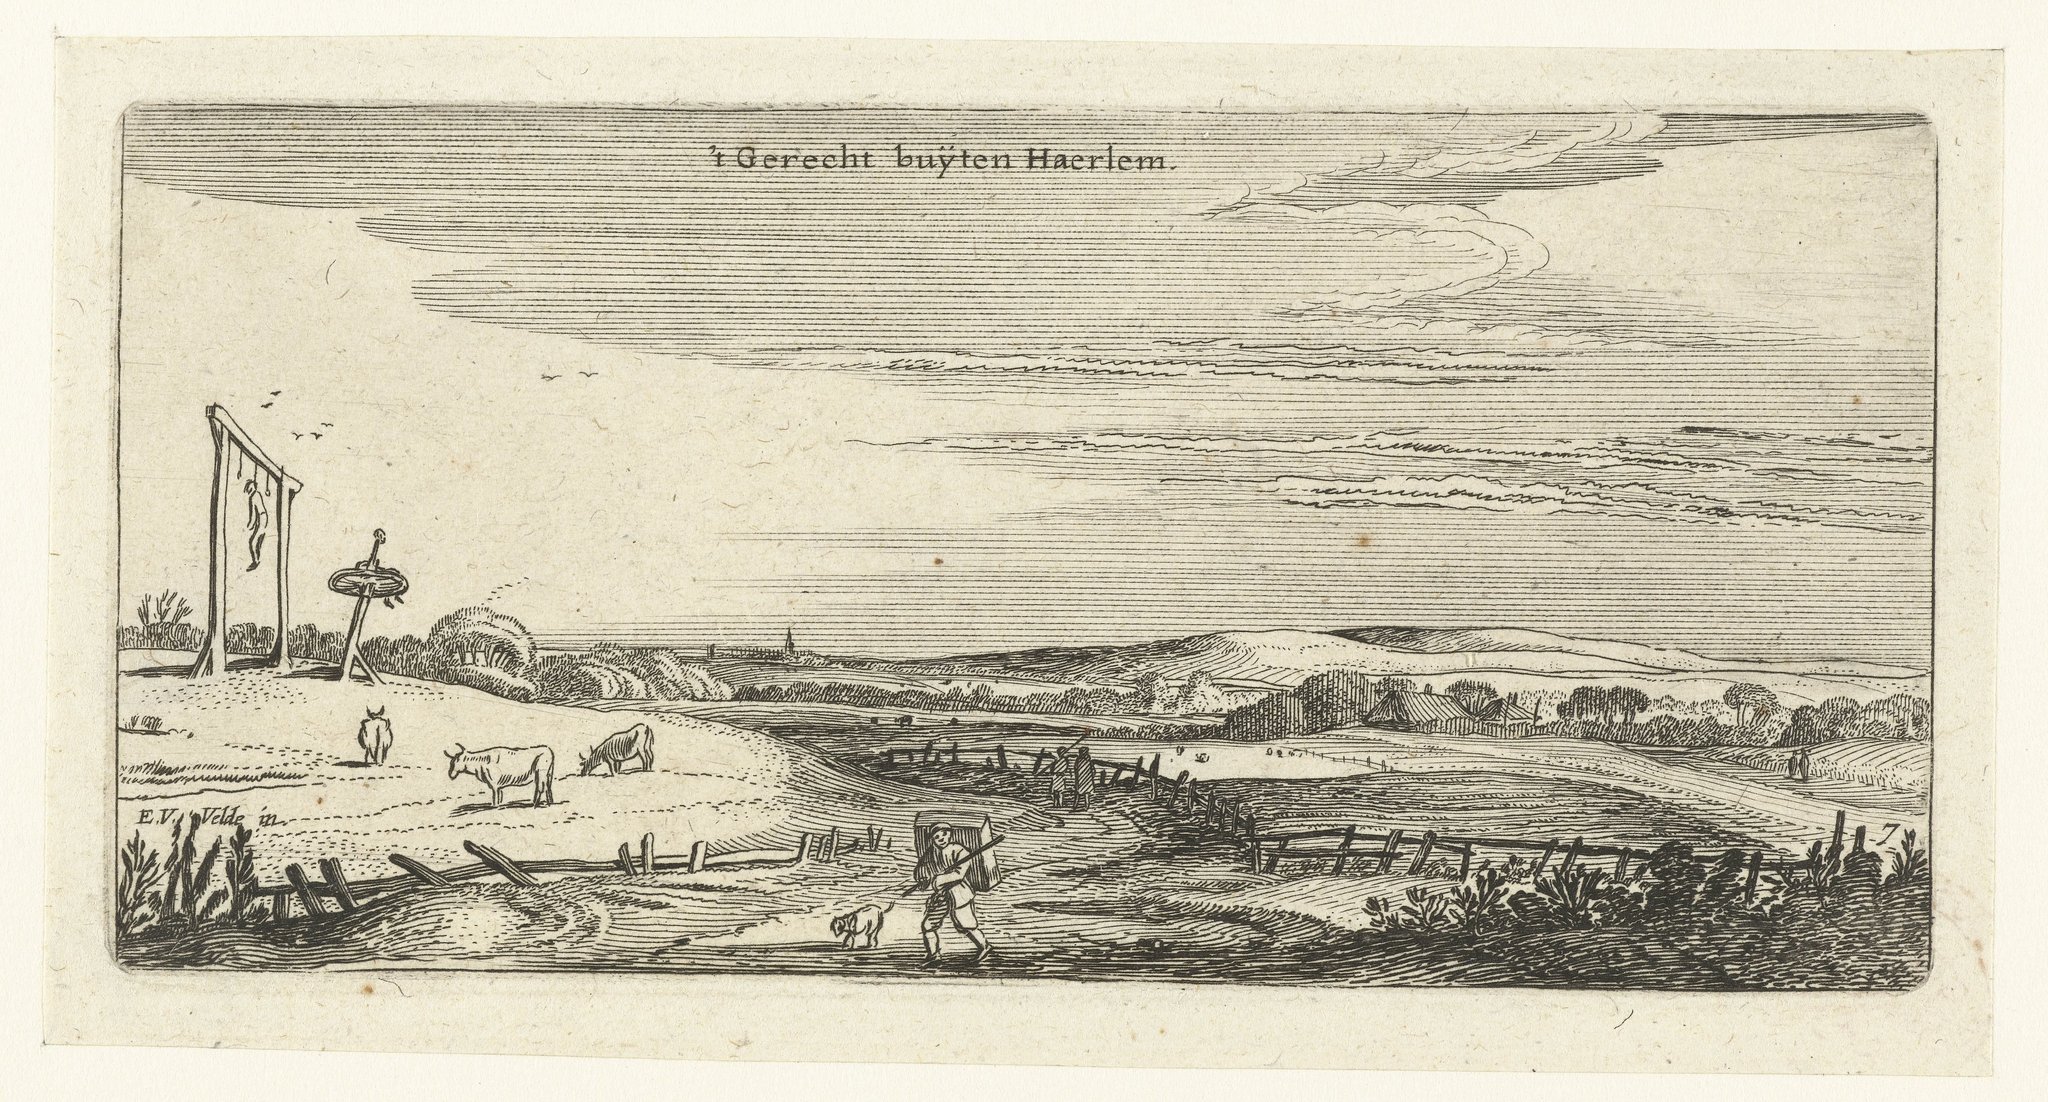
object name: print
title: Landschappen (kopieën)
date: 1615-1652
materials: paper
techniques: engraving, etching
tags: violent death by hanging, law and jurisprudence (+ place of execution), haarlem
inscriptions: collector's mark: Lugt 240